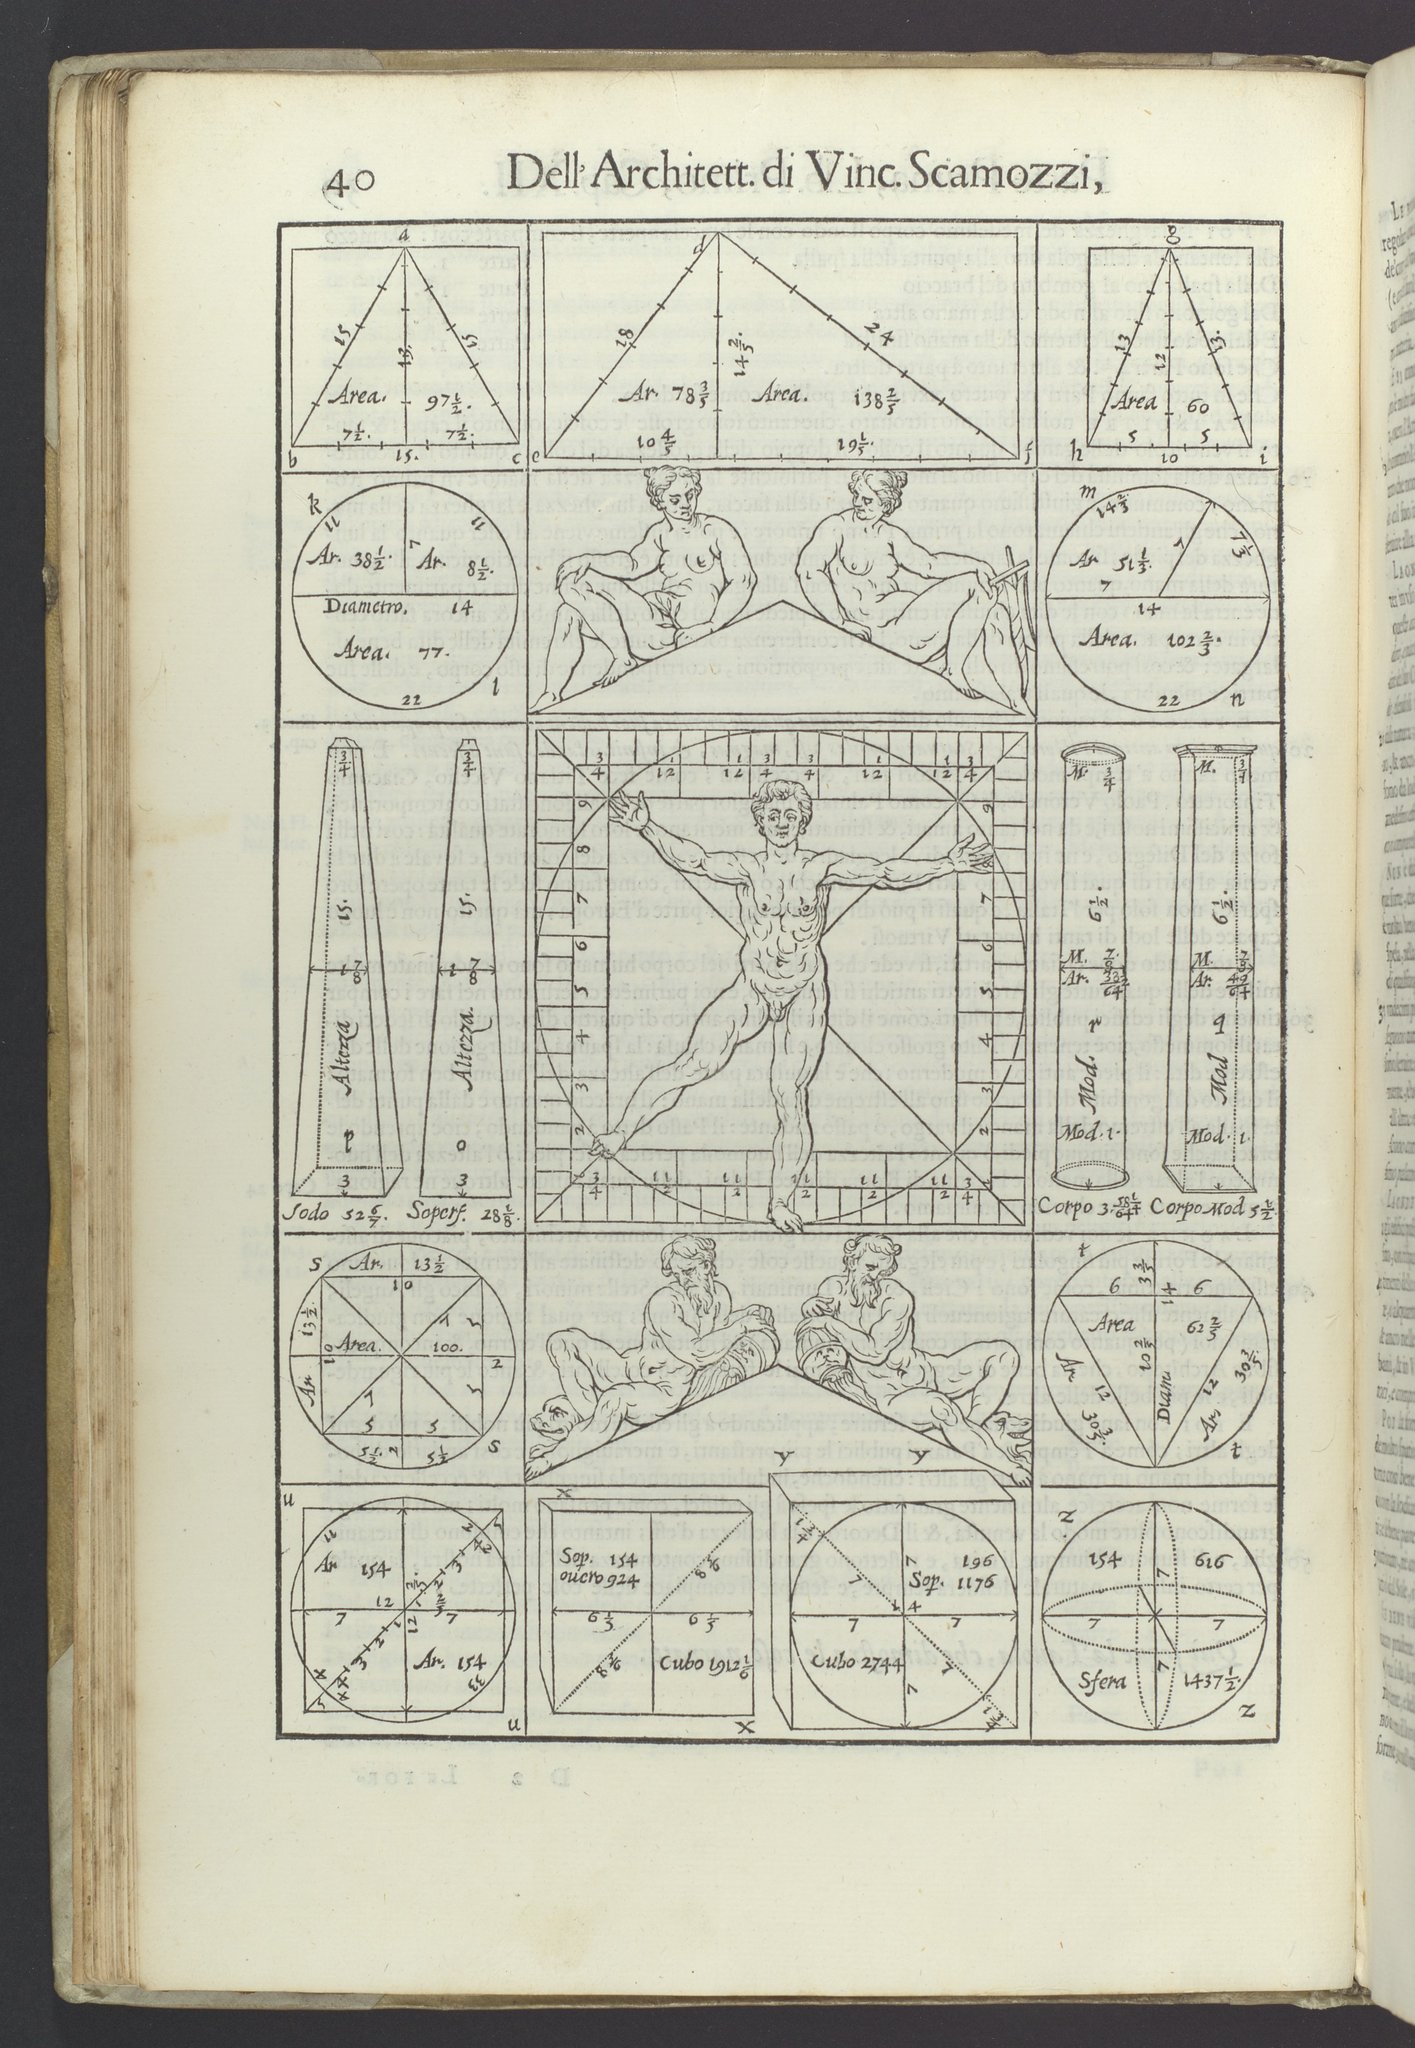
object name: book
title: L'Idea della Architettura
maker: vincenzo scamozzi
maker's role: author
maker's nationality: italian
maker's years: 1548-1616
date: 1615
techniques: engraving, printing, woodcut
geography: italy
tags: architecture